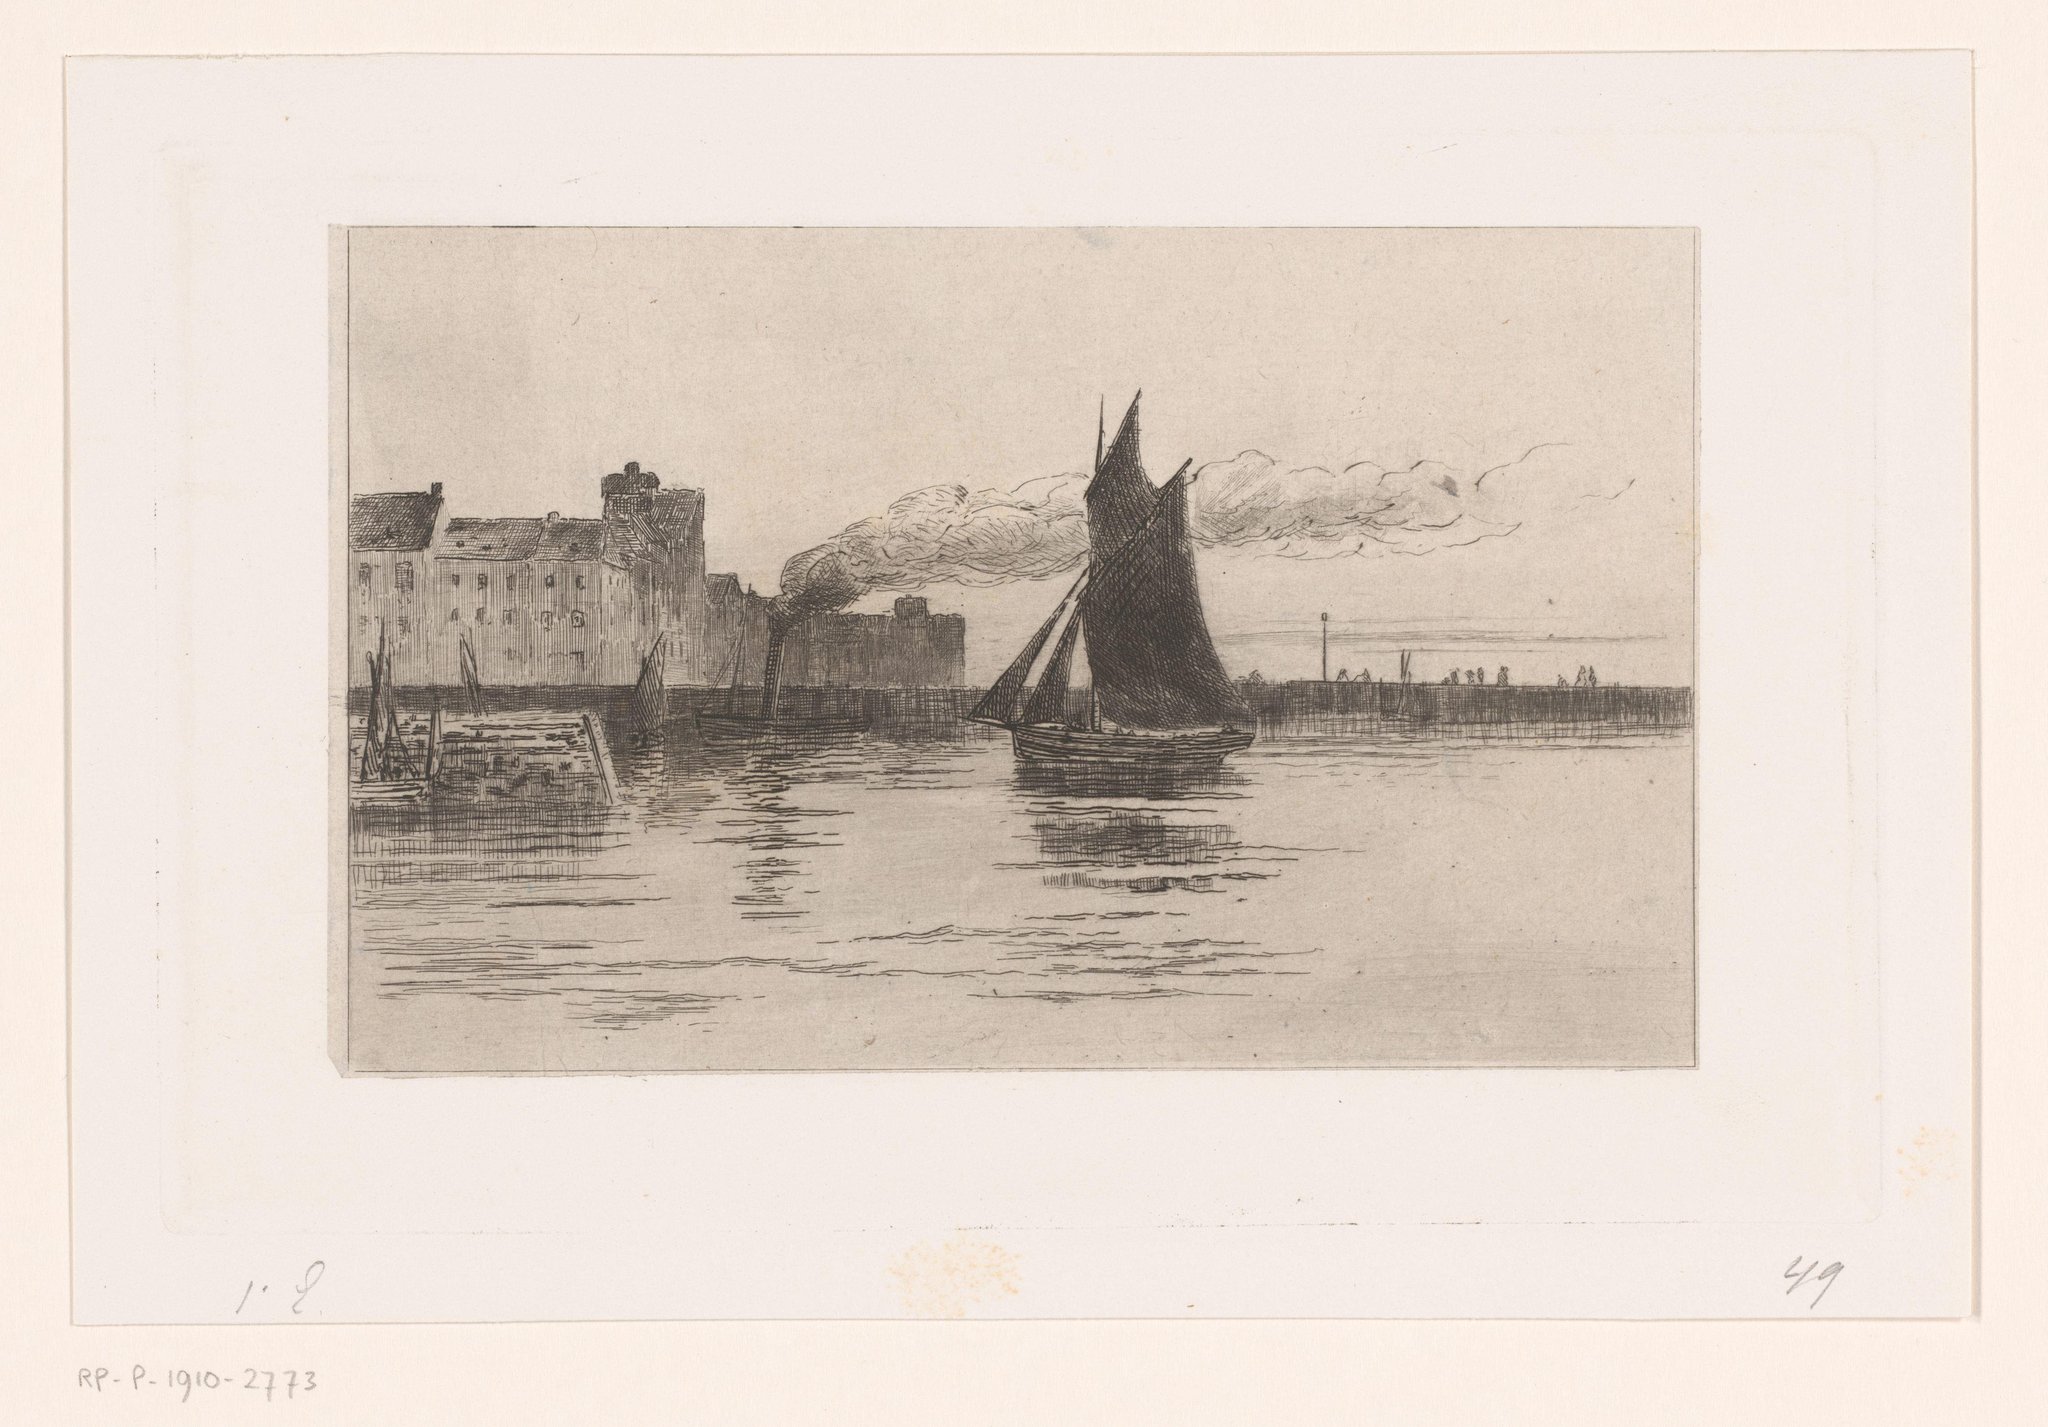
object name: print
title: Havengezicht met zeilboot in Honfleur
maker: carel nicolaas storm van s-gravesande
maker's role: draughtsman, print maker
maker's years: 1841-1924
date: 1873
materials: paper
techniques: etching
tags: harbour, sailing-ship, sailing-boat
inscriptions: collector's mark: Lugt 2228, title: ‘l'avant port à honfleur’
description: Op de achtergrond lopen mensen over de pier.